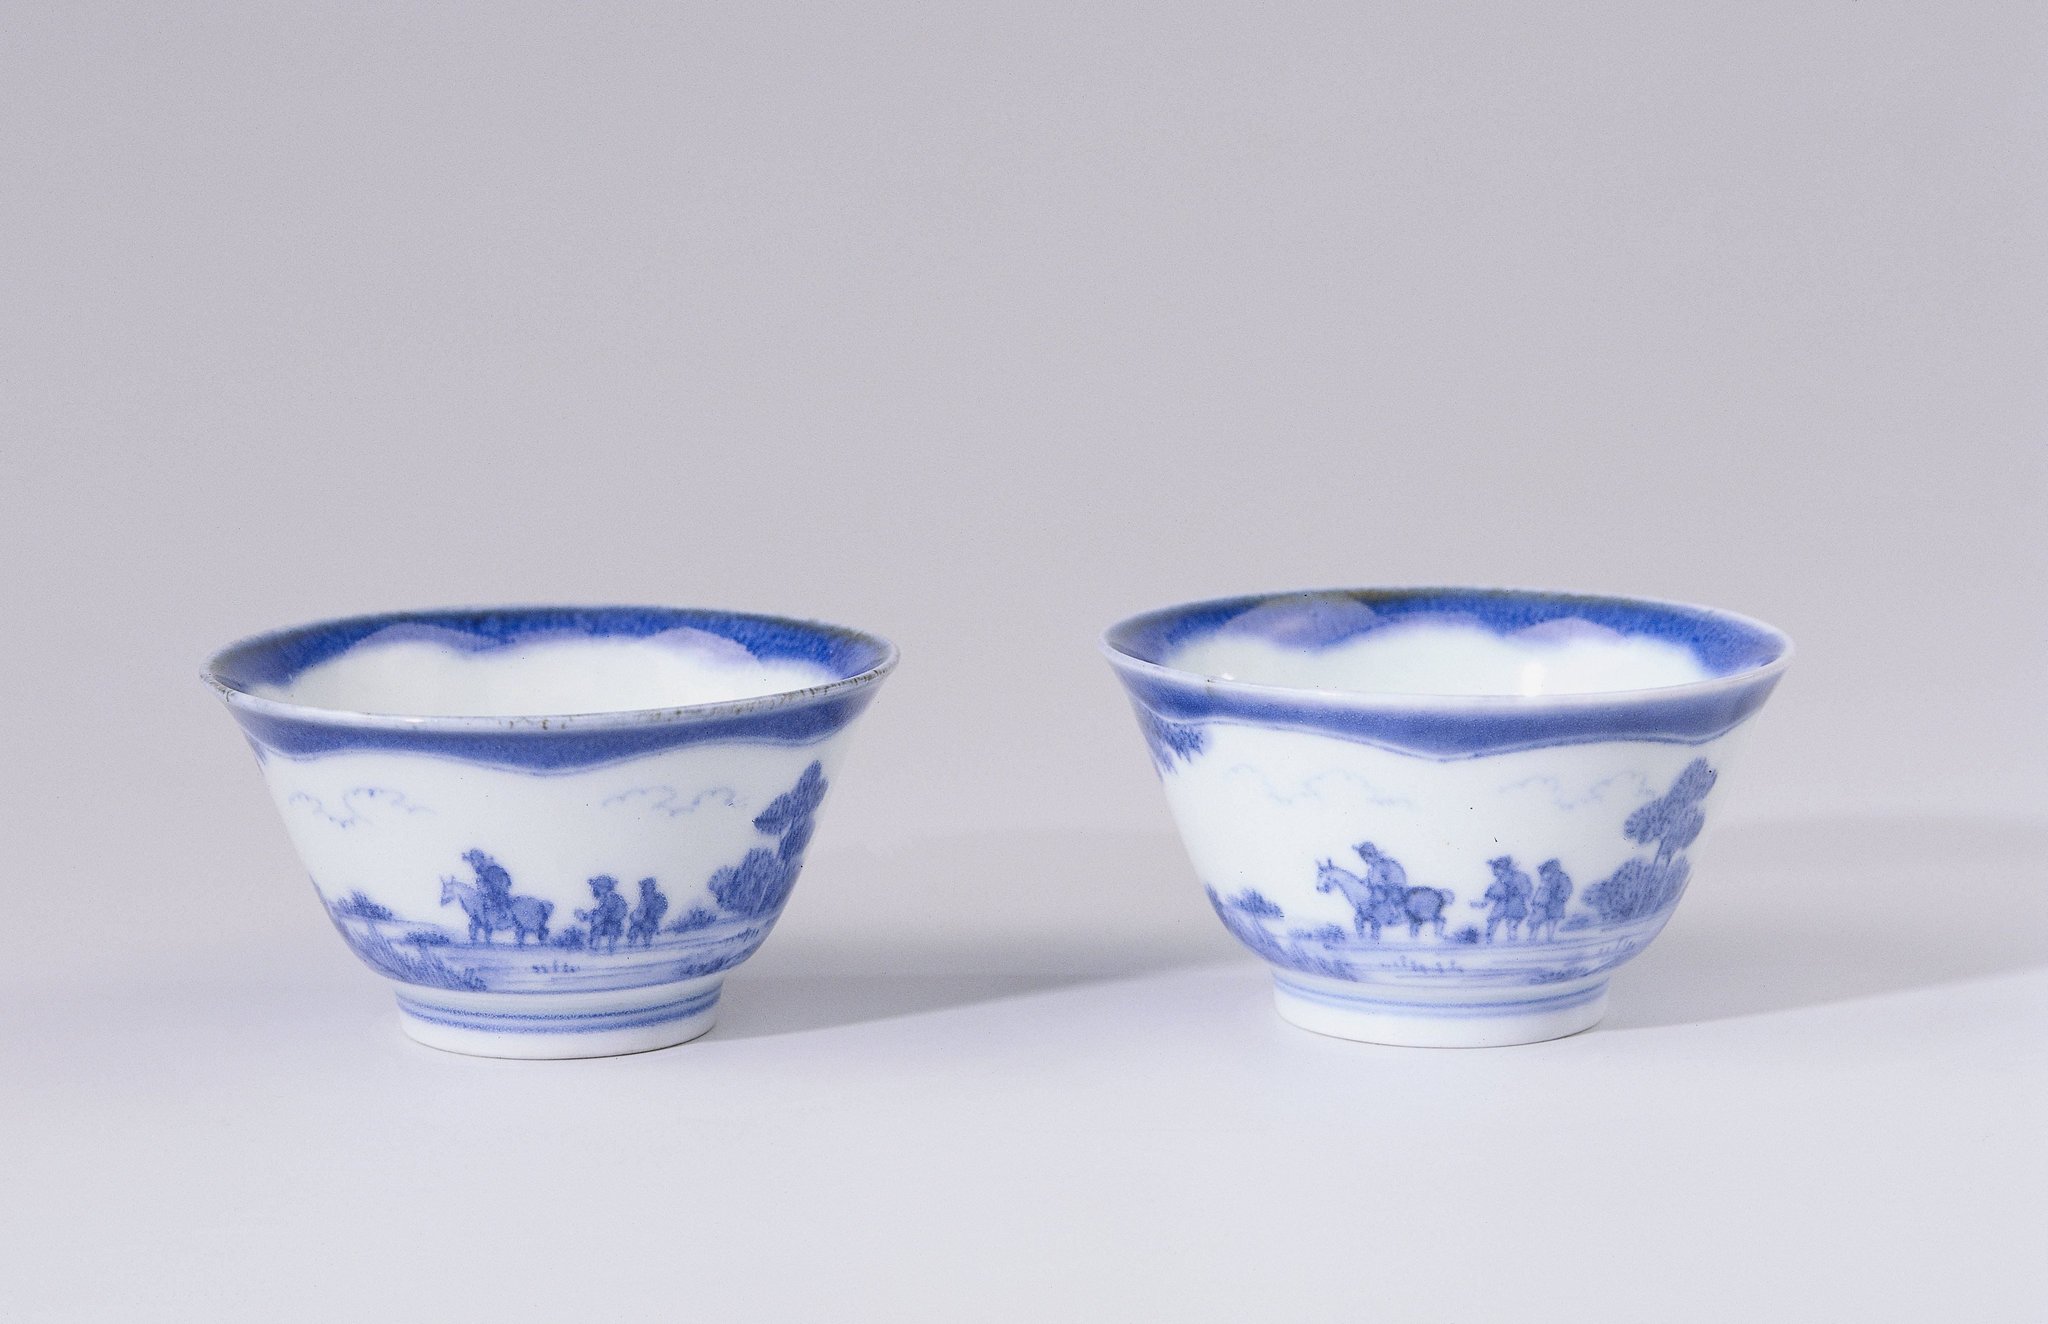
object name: cup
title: Bell-shaped cup with figures in a landscape with trees and rocks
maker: Anonymous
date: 1700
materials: cobalt, glaze, paint, porcelain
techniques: firing, turning, vitrification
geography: japan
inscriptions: mark: ‘大 明 年 製 dà míng nián zhì’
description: Klokvormige kop van porselein, beschilderd in onderglazuur blauw. Op de buitenwand een landschap met daarin een ruiter en twee lopende mensen tussen bomen en rotsen. Op de bodem een huis met een boom en een omheinde tuin; de binnenrand met een blauwe band. Gemerkt op de onderzijde met een vier-karakter Ming merk. Arita, blauw-wit.